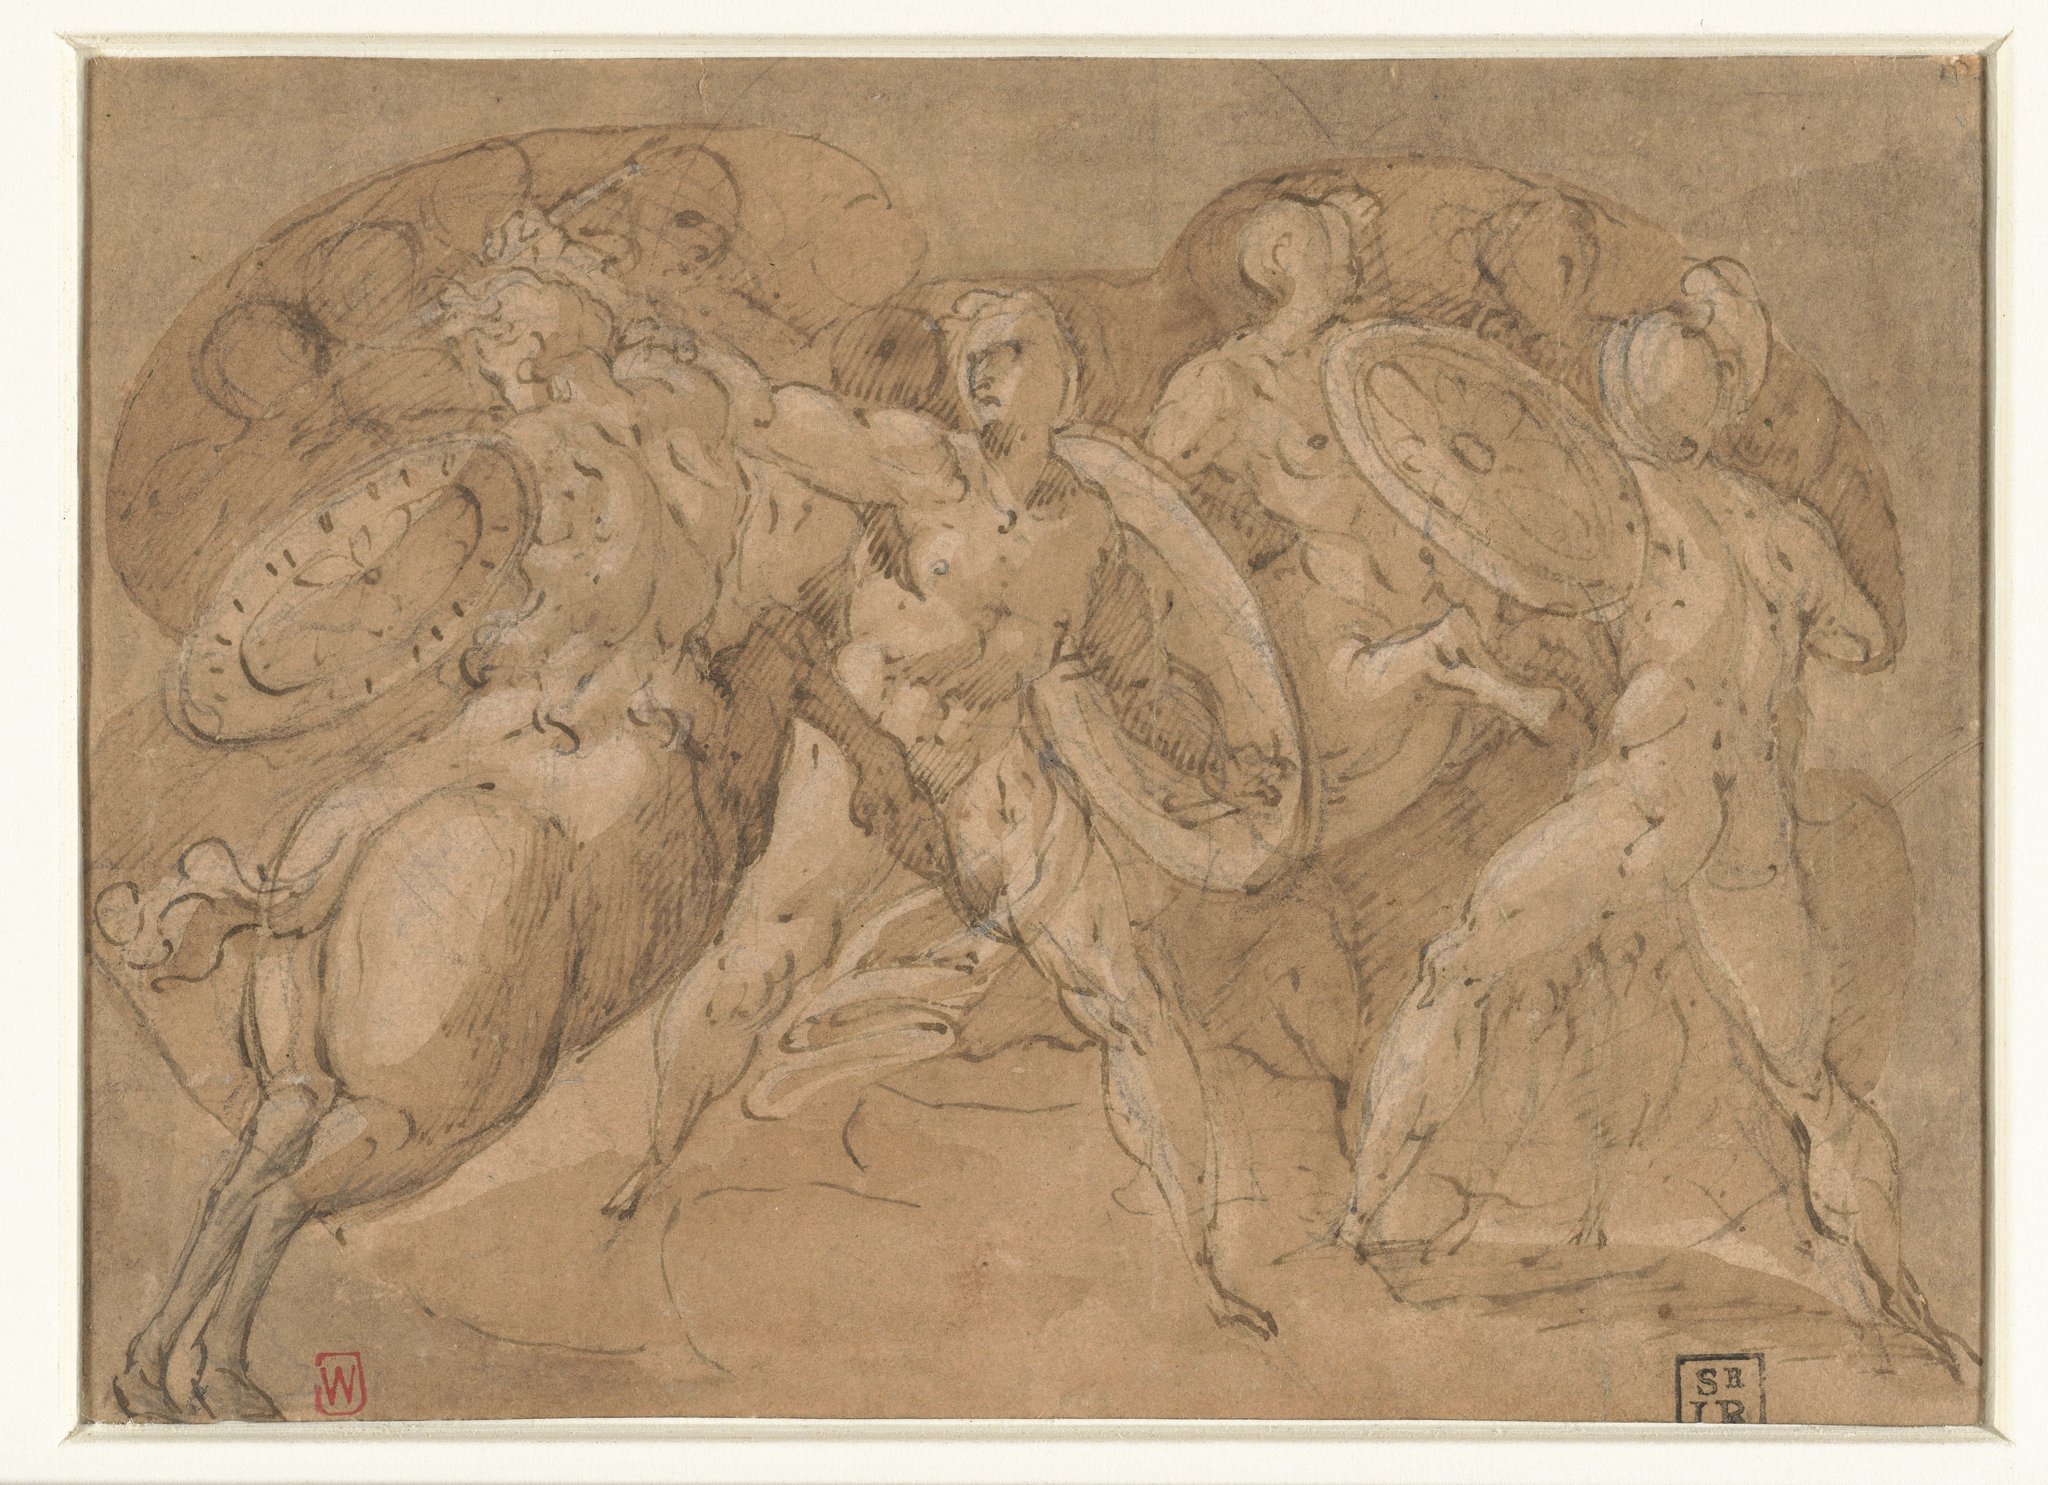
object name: drawing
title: Gevecht tussen Lapithen en Centauren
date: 1513-1620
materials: chalk, ink, paper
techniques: brush, pen